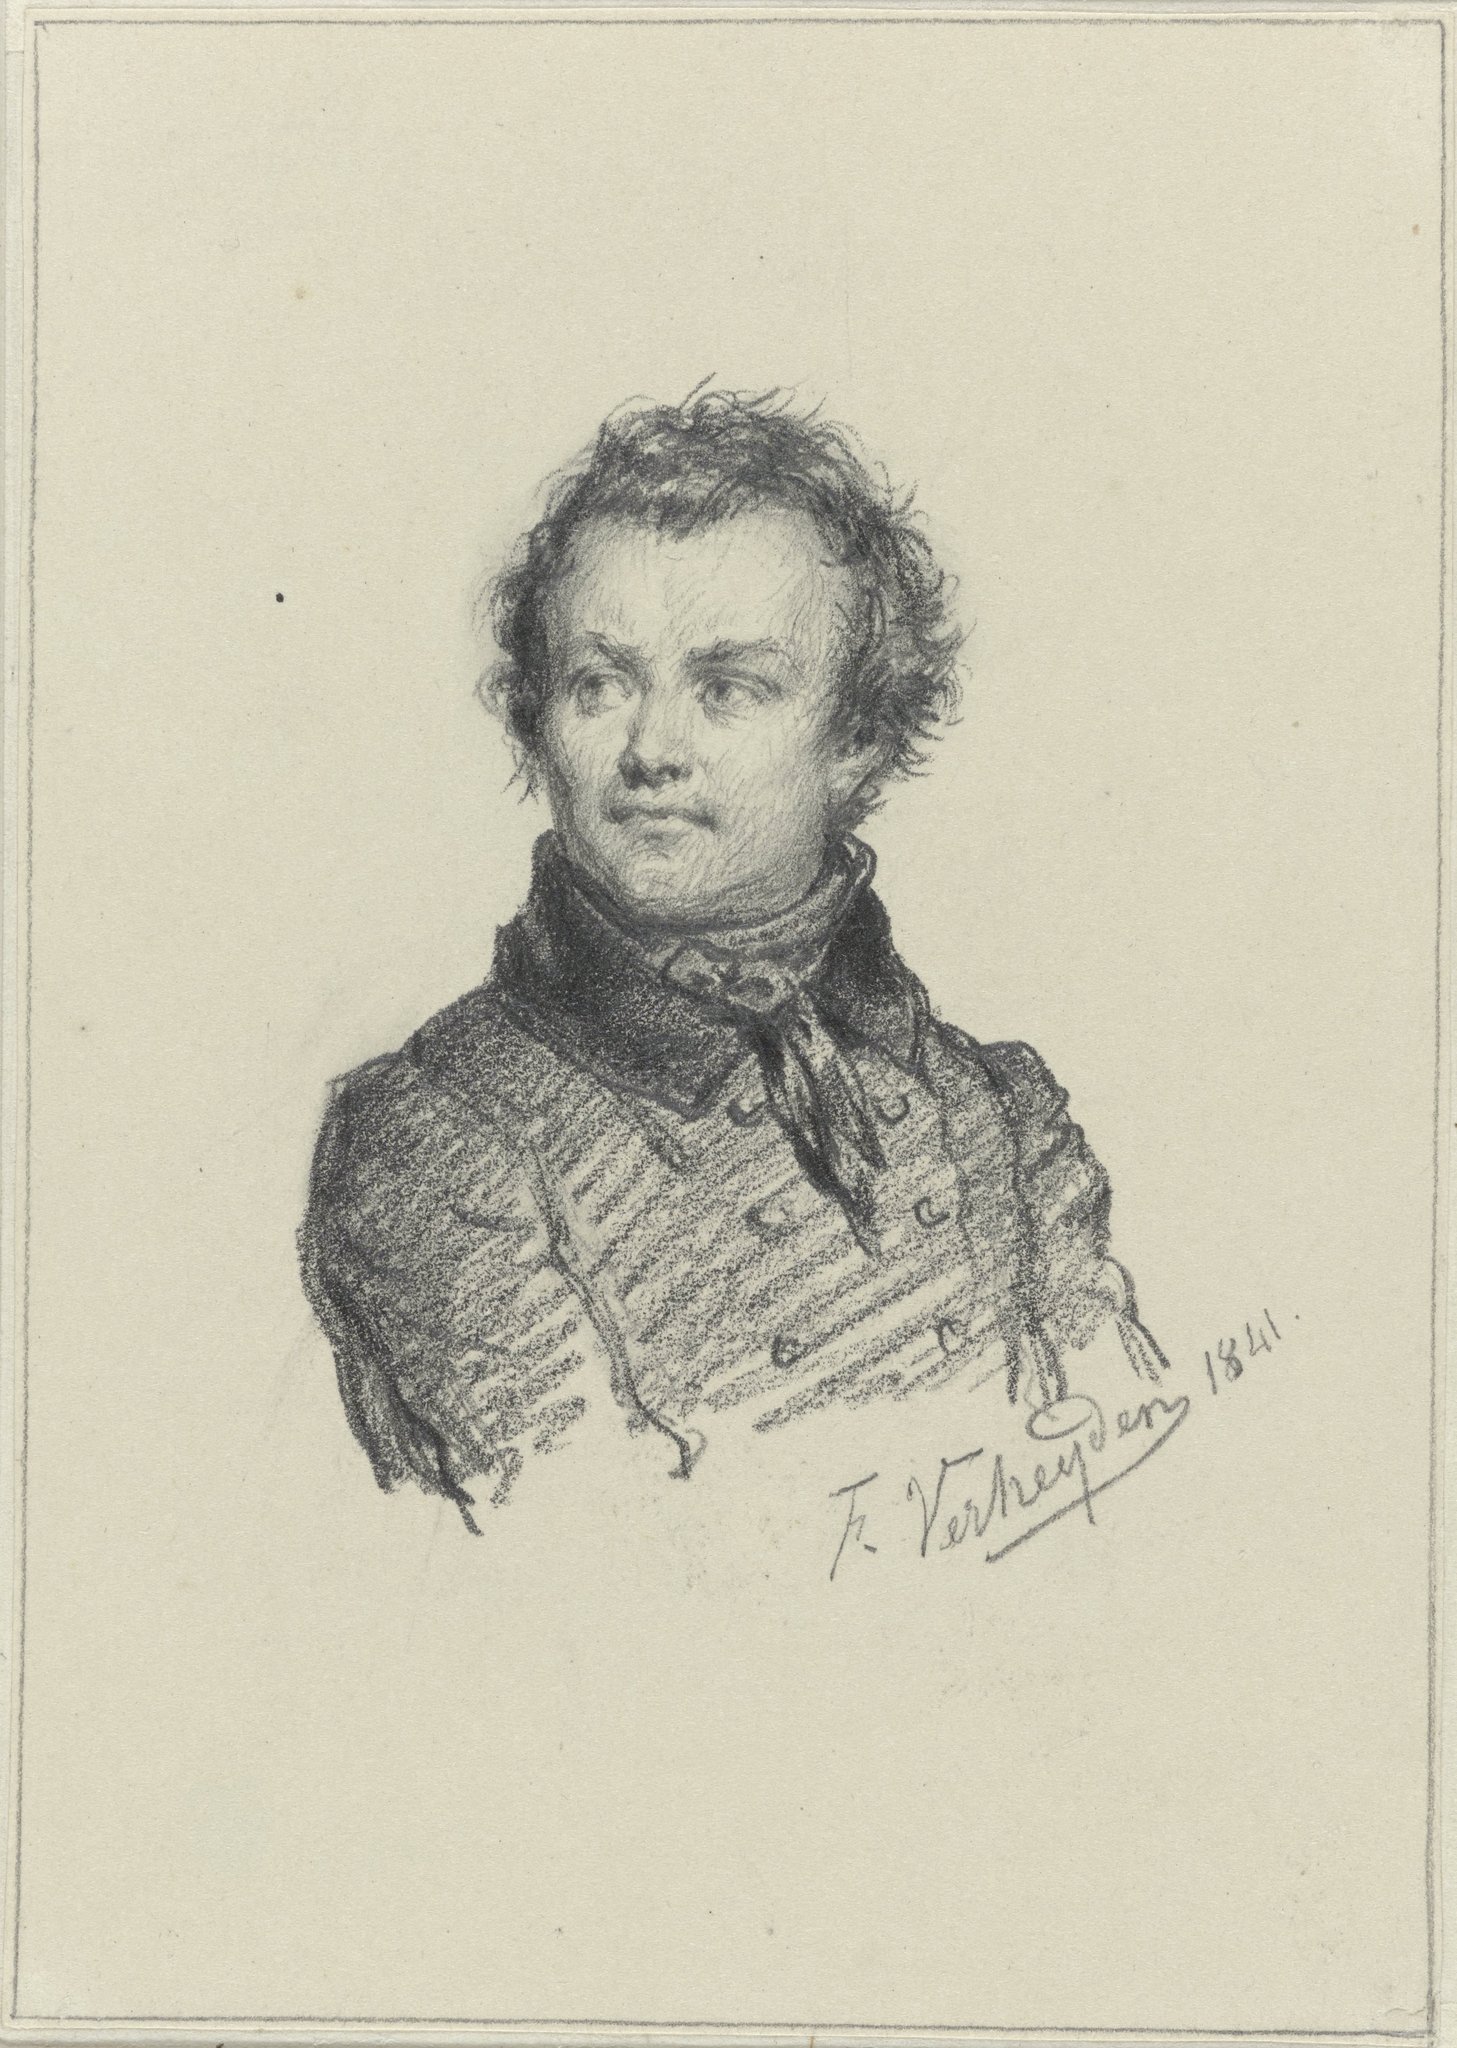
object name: drawing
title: Zelfportret van de schilder François Verheyden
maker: françois verheyden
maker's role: draughtsman, print maker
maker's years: 1806-1889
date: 1841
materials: paper, pencil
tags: louvain, brussels, print maker, draughtsman, françois verheyden, historical persons, portrait, self-portrait of painter, portrait, self-portrait of artist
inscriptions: date: ‘1841’